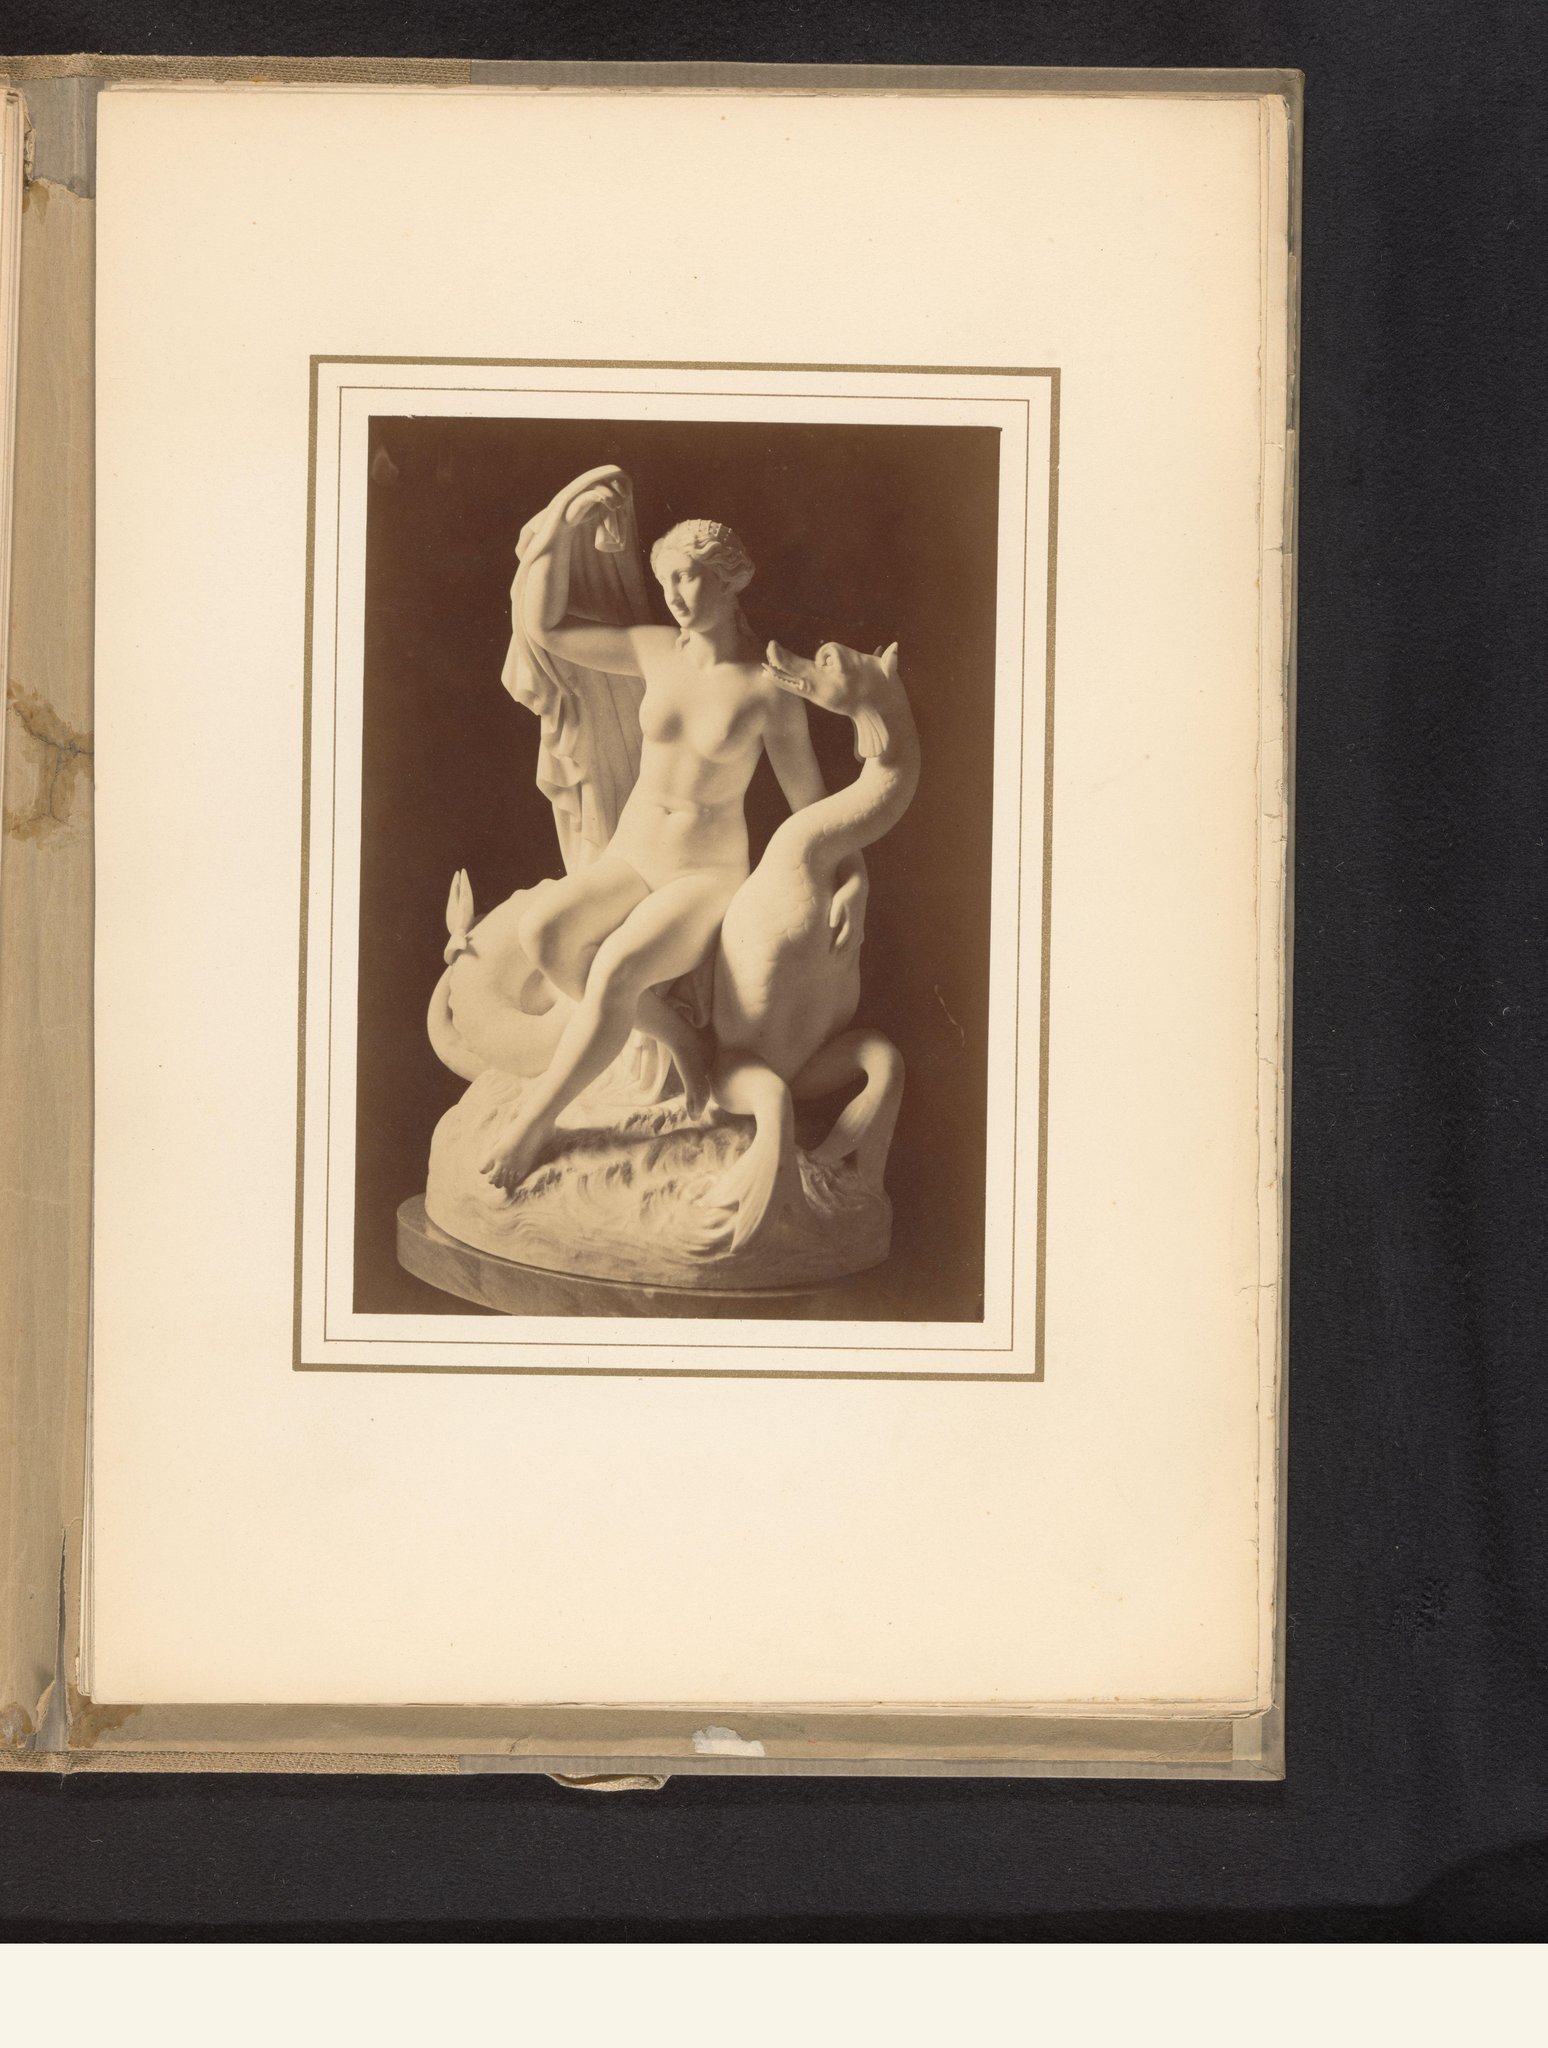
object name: photograph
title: Sculptuur van een vrouw en een draak door Leopold Borbone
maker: grillet jeune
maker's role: fotograaf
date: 1854-1859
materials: photographic support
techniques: albumen print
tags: adult woman, piece of sculpture, reproduction of a piece of sculpture, dragon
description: Deze foto maakt deel uit van een omslag met 18 foto's op 18 bladen en 14 tekstbladen.